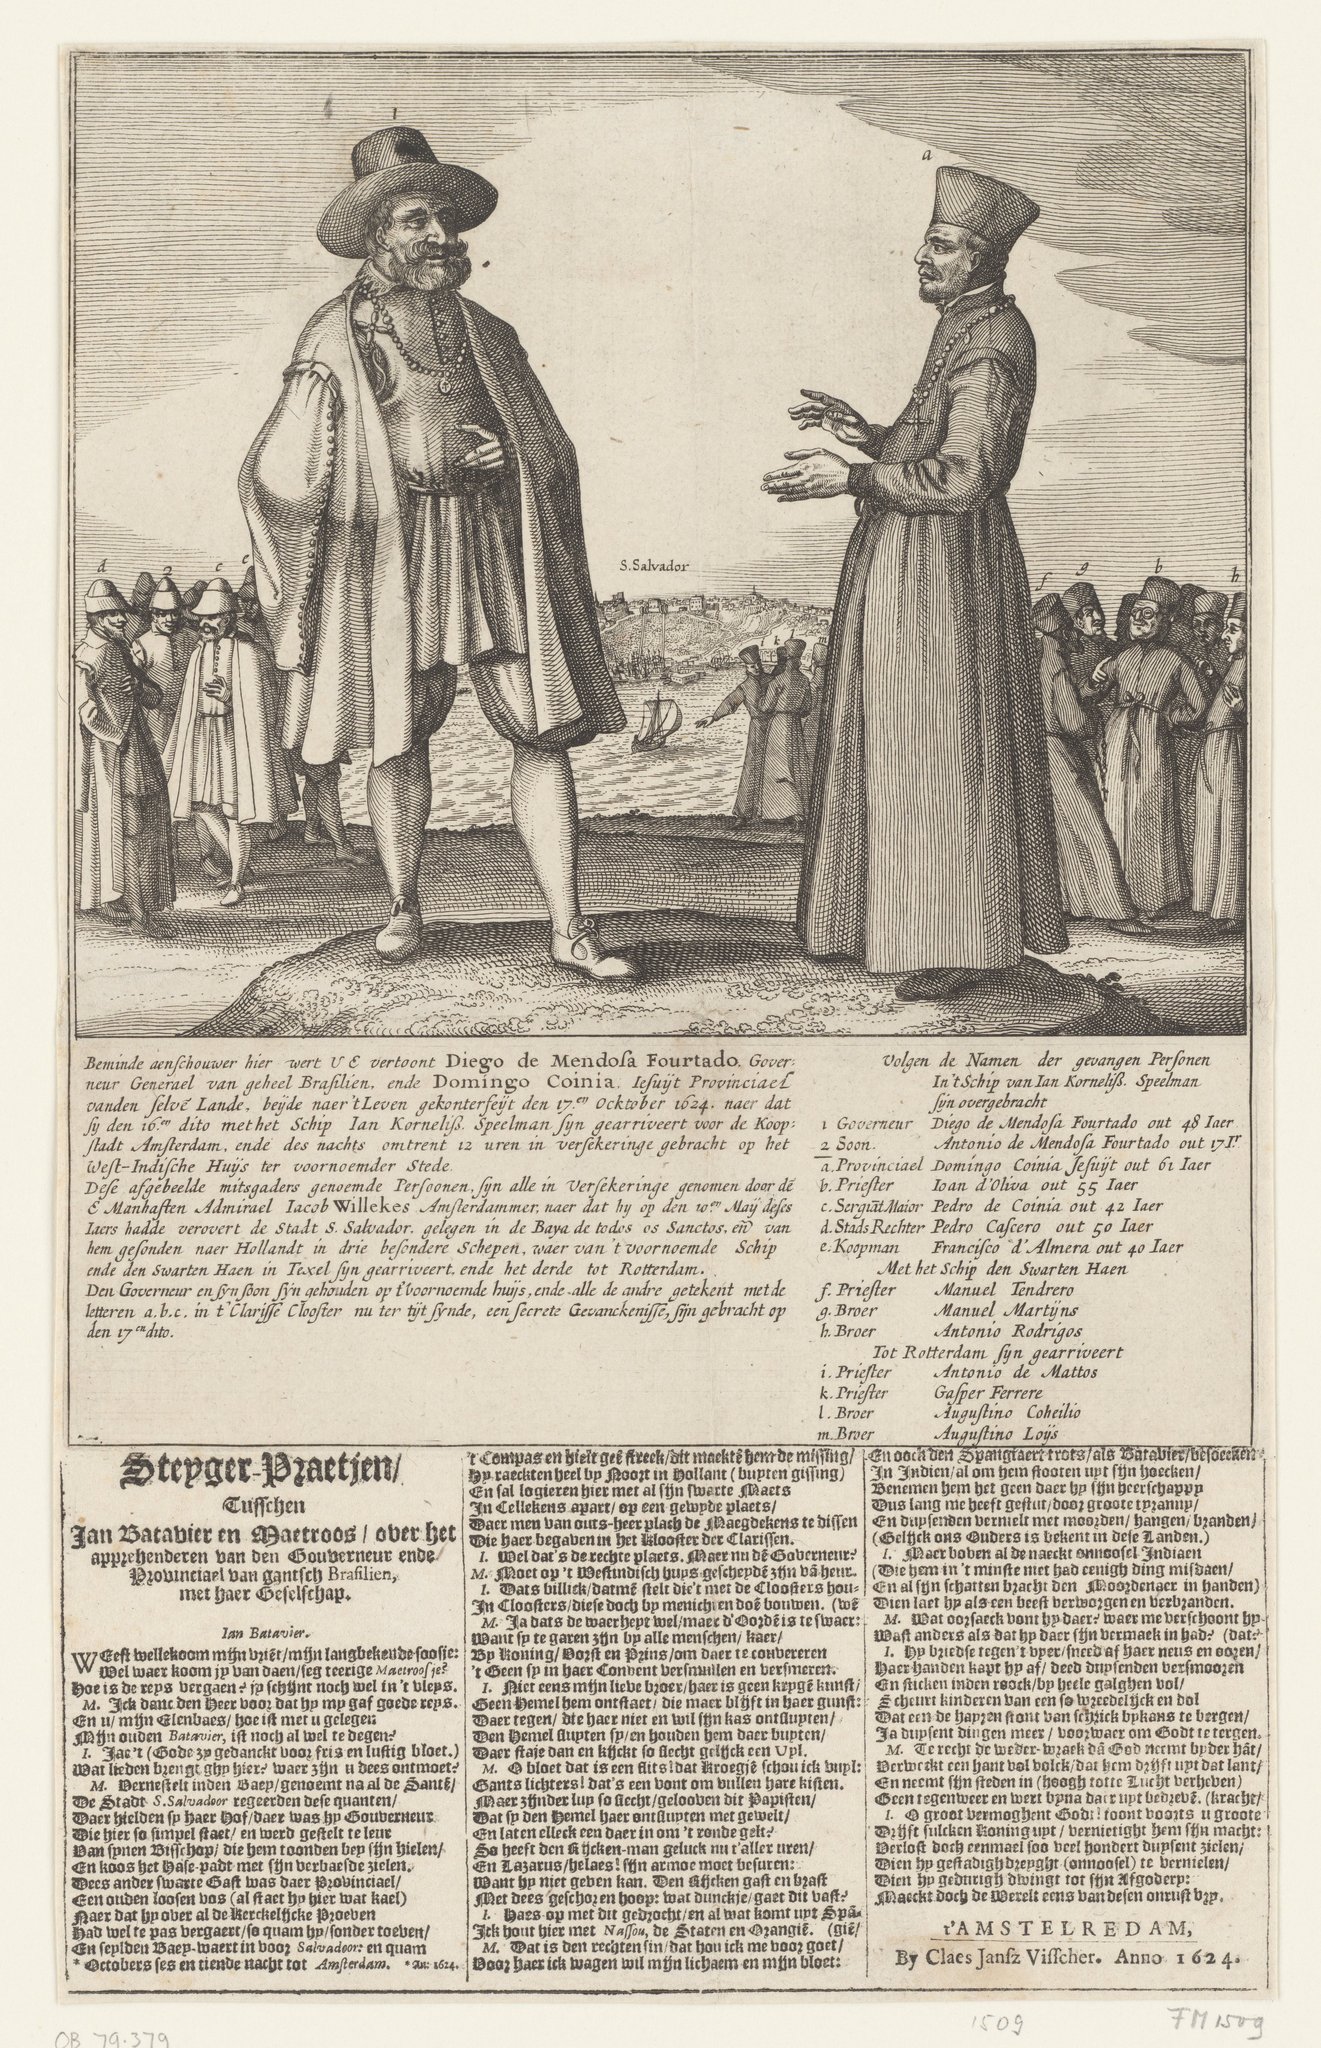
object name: print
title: Diego de Mendoza Furtado, gouverneur-generaal van Brazilië en de jezuïet Domingo Coina, gevangengenomen door de Nederlanders, 1624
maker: claes jansz. visscher (ii)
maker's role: draughtsman, print maker, publisher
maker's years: 1586-1652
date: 1624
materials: paper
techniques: etching, letterpress printing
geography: amsterdam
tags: prisoner; in fetters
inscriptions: date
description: Diego de Mendosa Furtado, gouverneur-generaal van Brazilië en de jezuïet Domingo Coina, ten voeten uit staande naast elkaar, 17 oktober 1624. Beide mannen gevangengenomen door de Nederlanders bij de inname van Salvador door Jacob Willekes en afgevoerd naar Amsterdam waar zij op 16 oktober arriveerden en gevangen werden gezet in het West-Indisch Huis. Op de achtergrond andere leden van hun gezelschap en de stad Salvador. Met teksten in en onder de plaat.